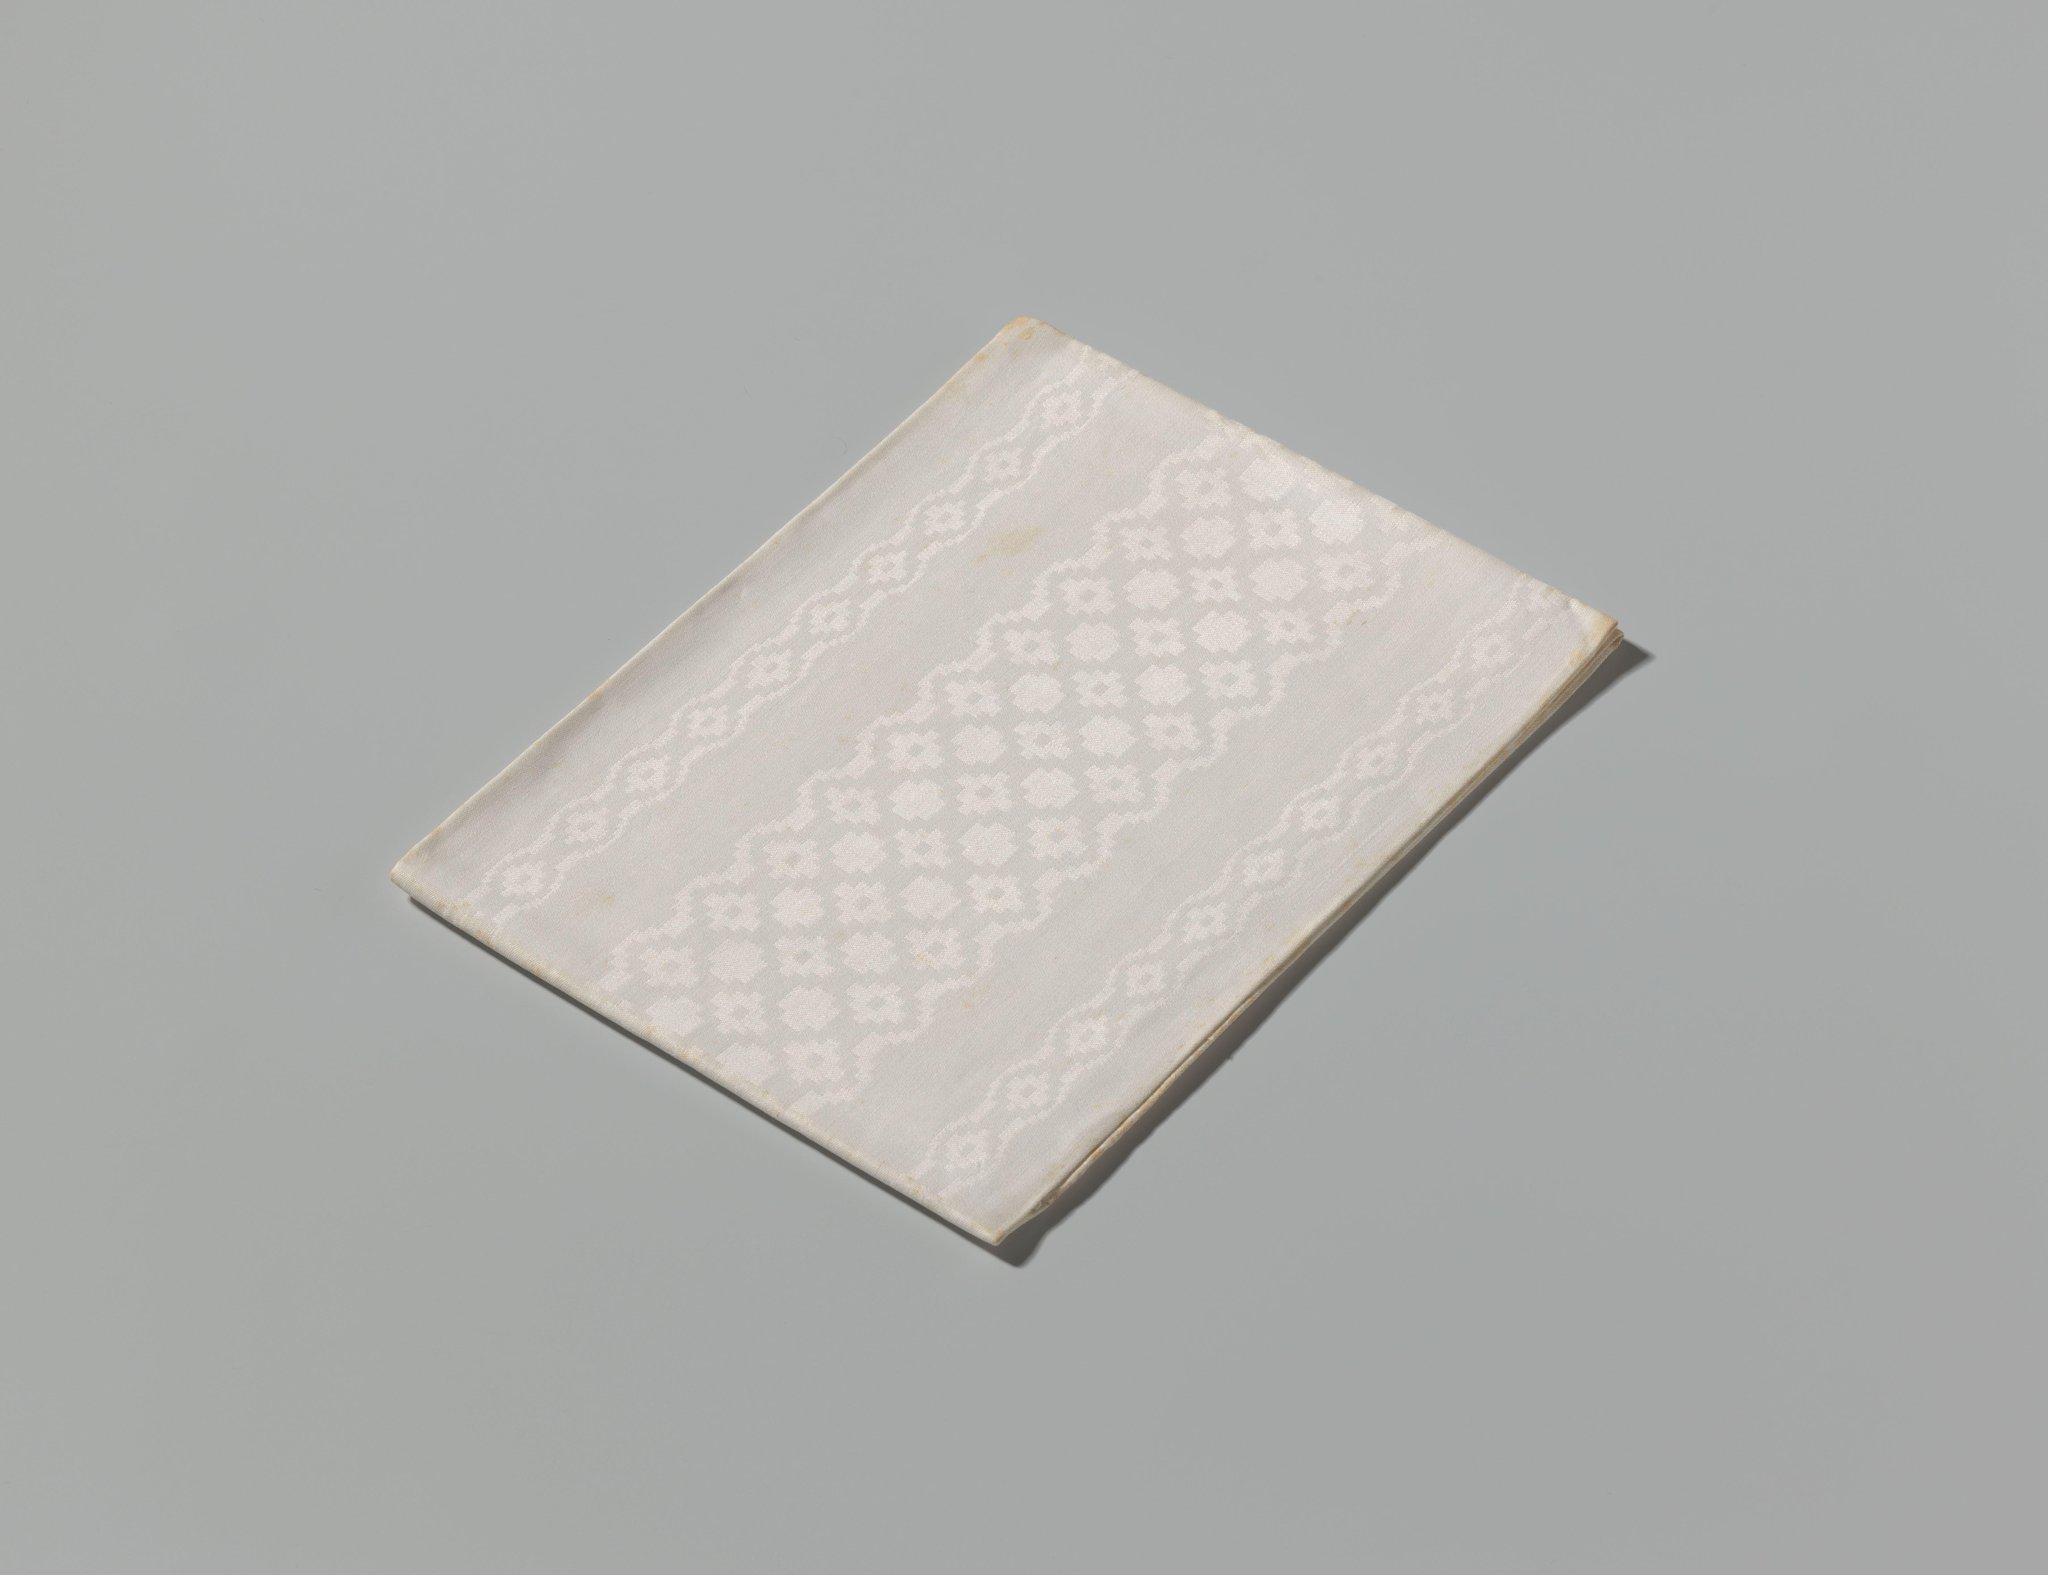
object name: napkin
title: Servet van pellendamast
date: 1850-1875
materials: linen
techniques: cross stitching, weave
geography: north brabant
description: Servet van linnen pellendamast. Het veld heeft vier brede banen met golvende randen, waarbinnen ruitvormen. Tussen de banen lopen effen banen waarbinnen een smalle band met golvende randen waarbinnen ruitvormen. Tussen het veld en de liggende rand vierkante blokken. De randen zijn gestreept. Het servet is in rood met een kruissteek gemerkt: GR 24 en heeft een aangenaaid nummer 1193 in rood op wit.